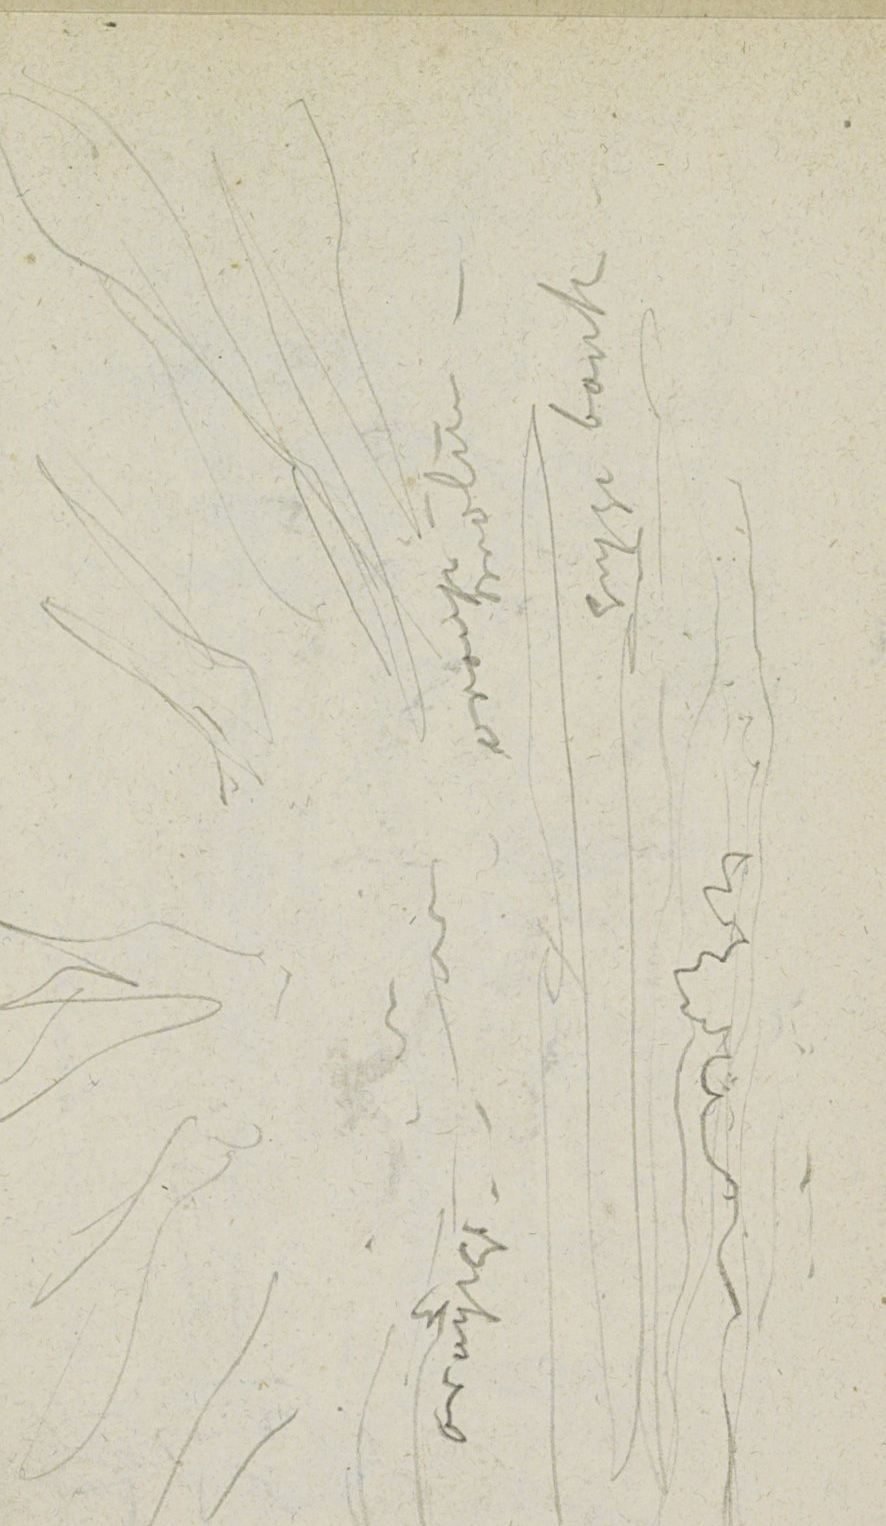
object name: sketchbook leaf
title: Landschap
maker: johannes tavenraat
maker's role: draughtsman, painter, print maker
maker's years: 1809-1881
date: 1854-1868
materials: paper, pencil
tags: landscapes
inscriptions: kleurnotitie, handgeschreven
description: Blad 62 recto uit een schetsboek met 88 bladen.